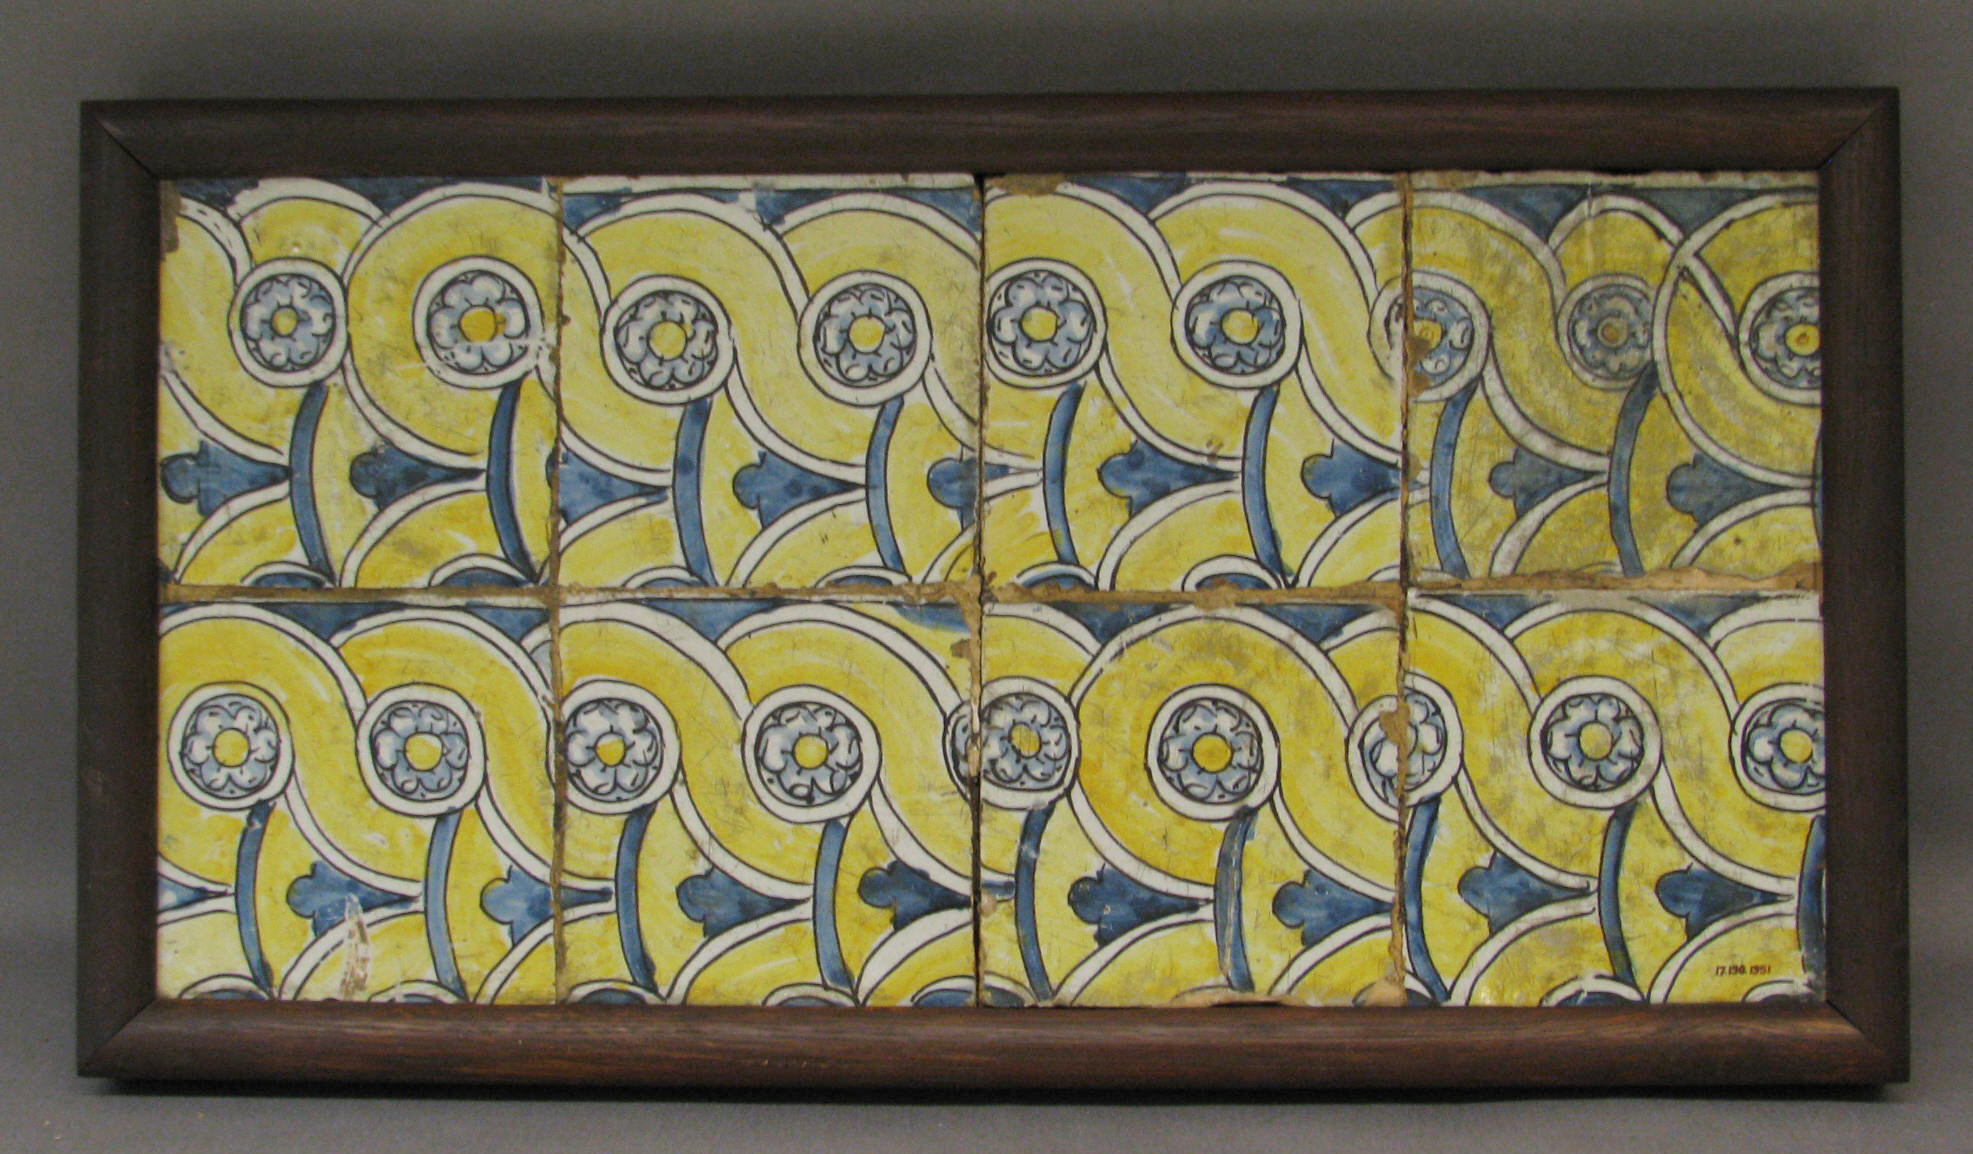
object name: tile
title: Panel of tiles (8)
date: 1660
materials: faience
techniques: glazing